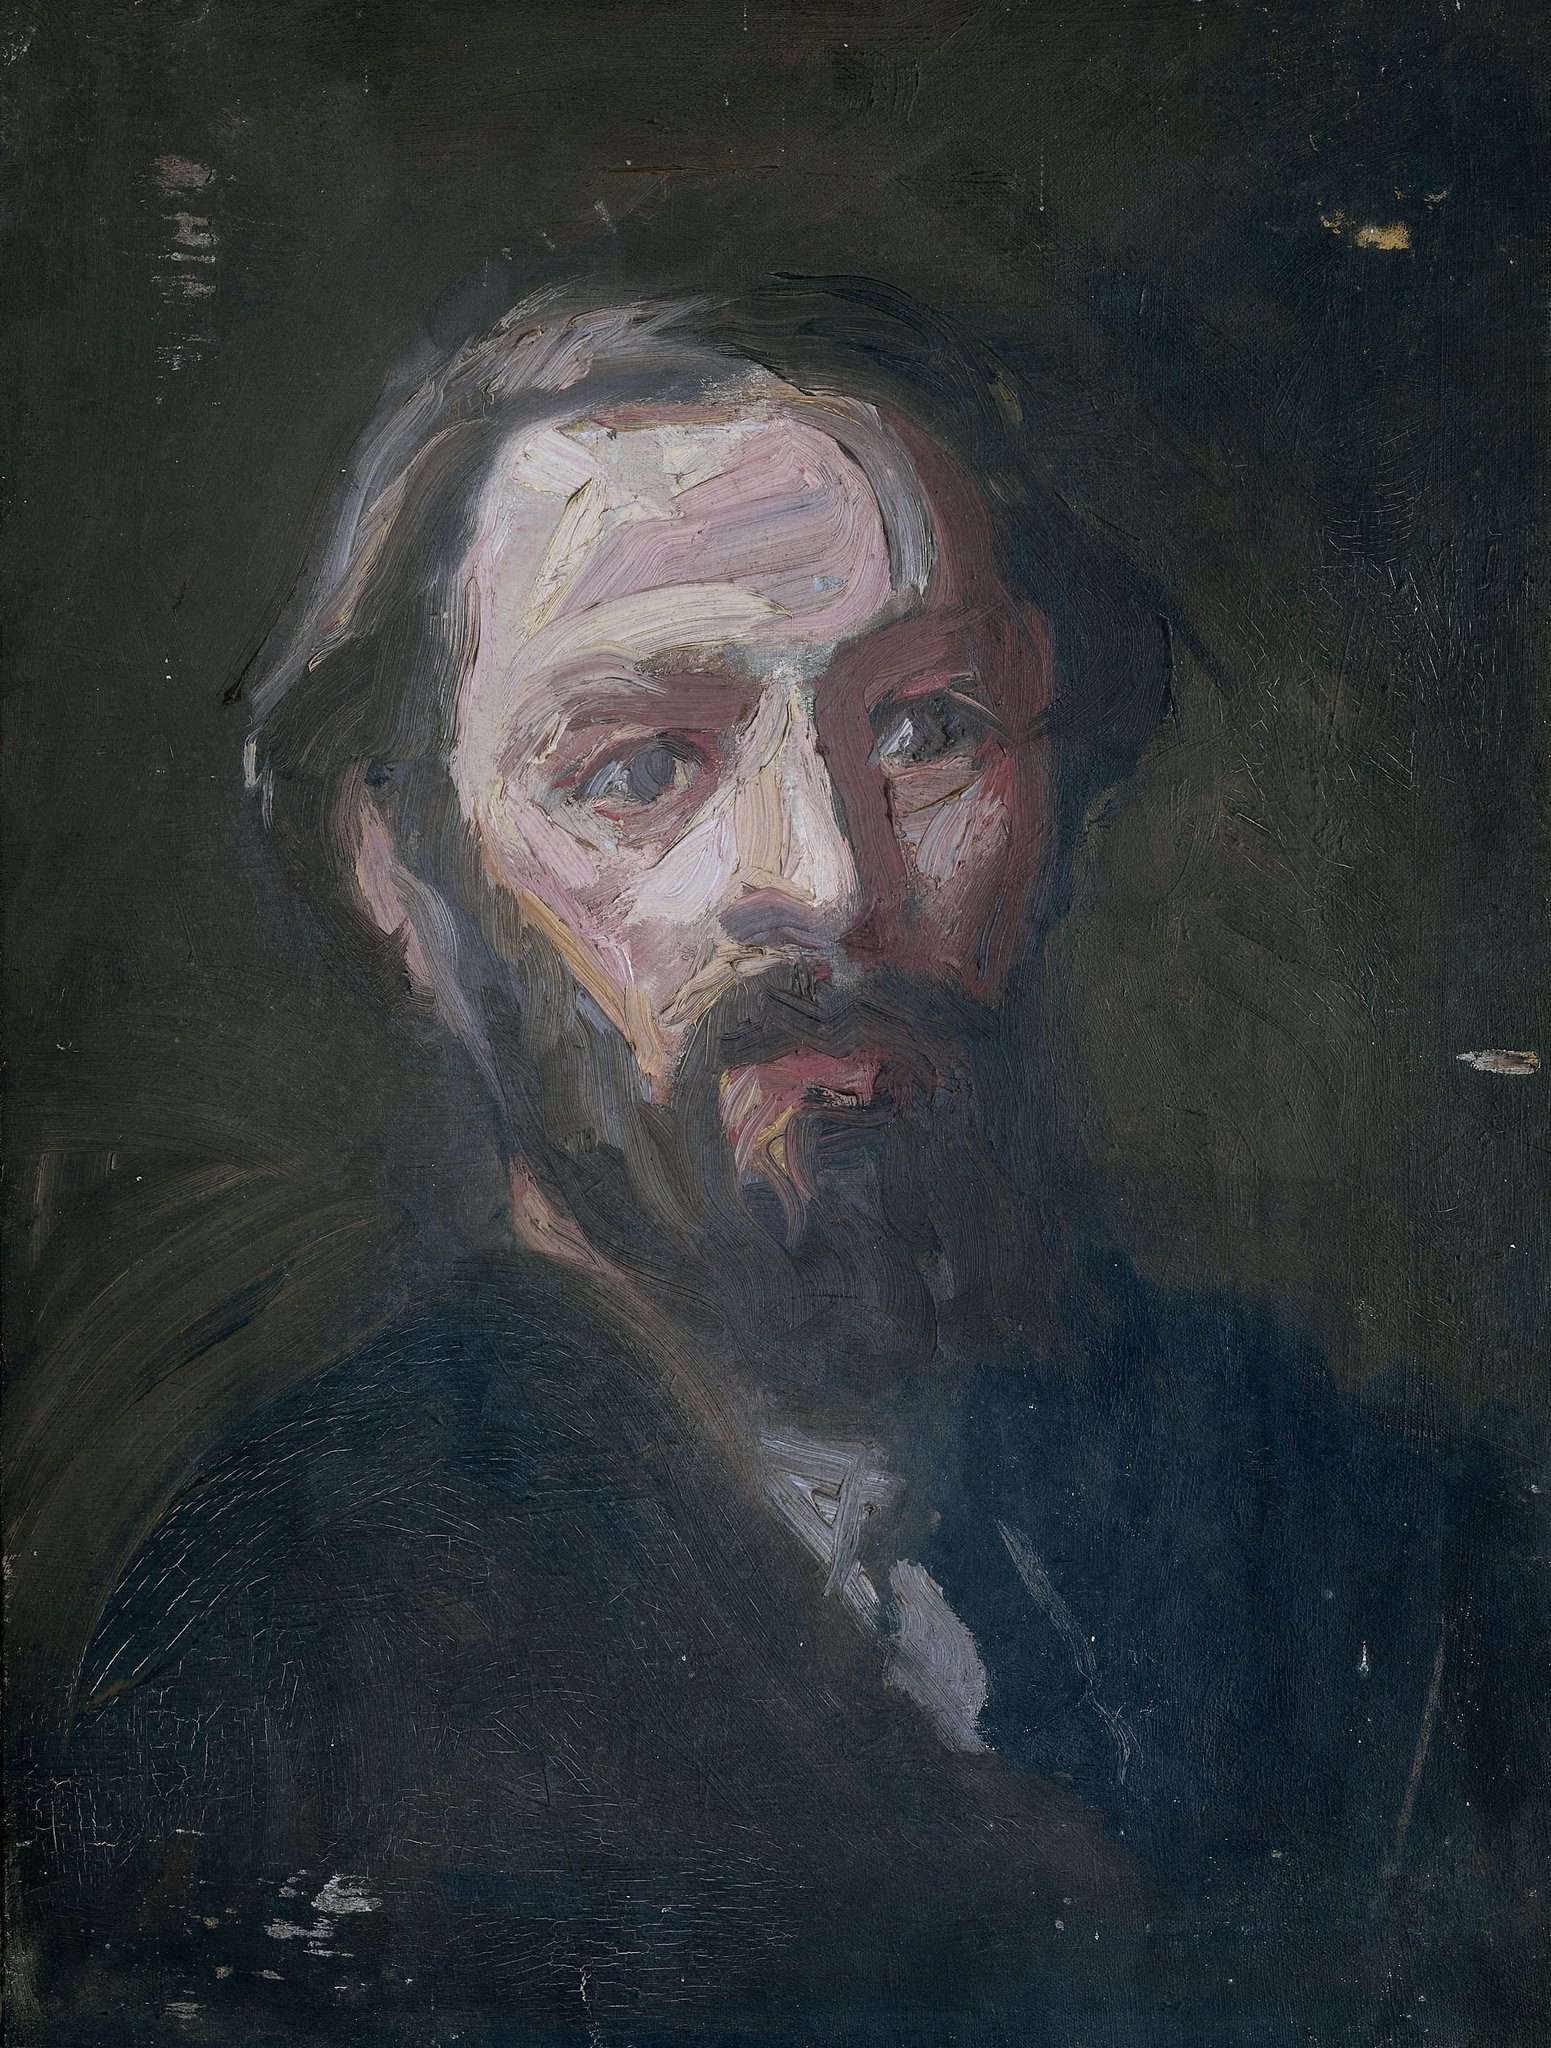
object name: painting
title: Portret van de beeldhouwer Pier Pander (1864-1919)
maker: thomas cool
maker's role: draughtsman, painter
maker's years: 1851-1904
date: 1893-1894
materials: canvas, oil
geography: rome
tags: rome, draughtsman, designer, pier pander, portrait, self-portrait of sculptor, portrait, self-portrait of artist